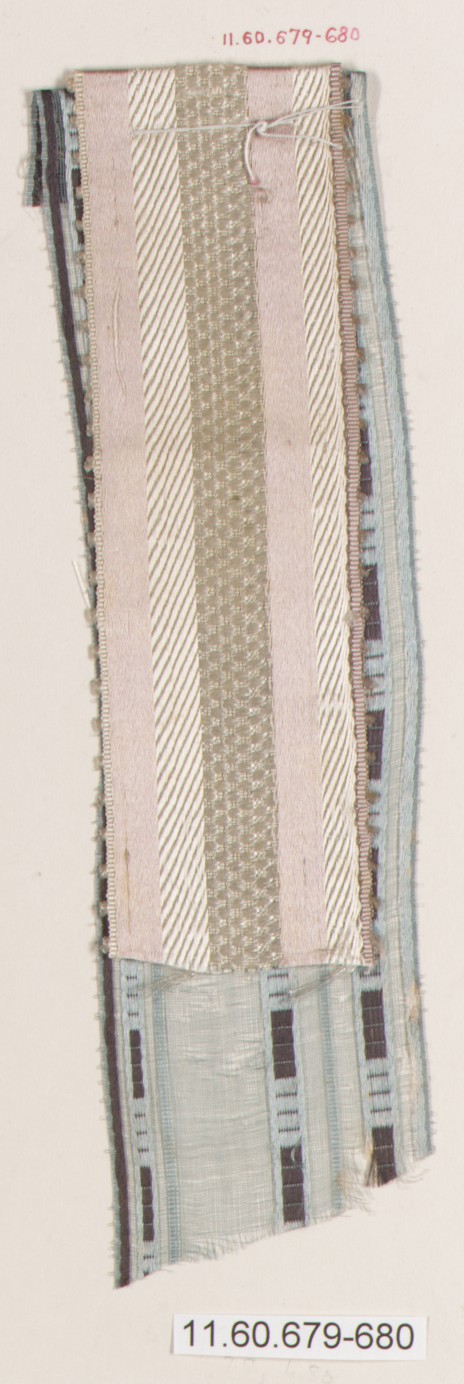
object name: ribbon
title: Ribbons (2)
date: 1801-1900